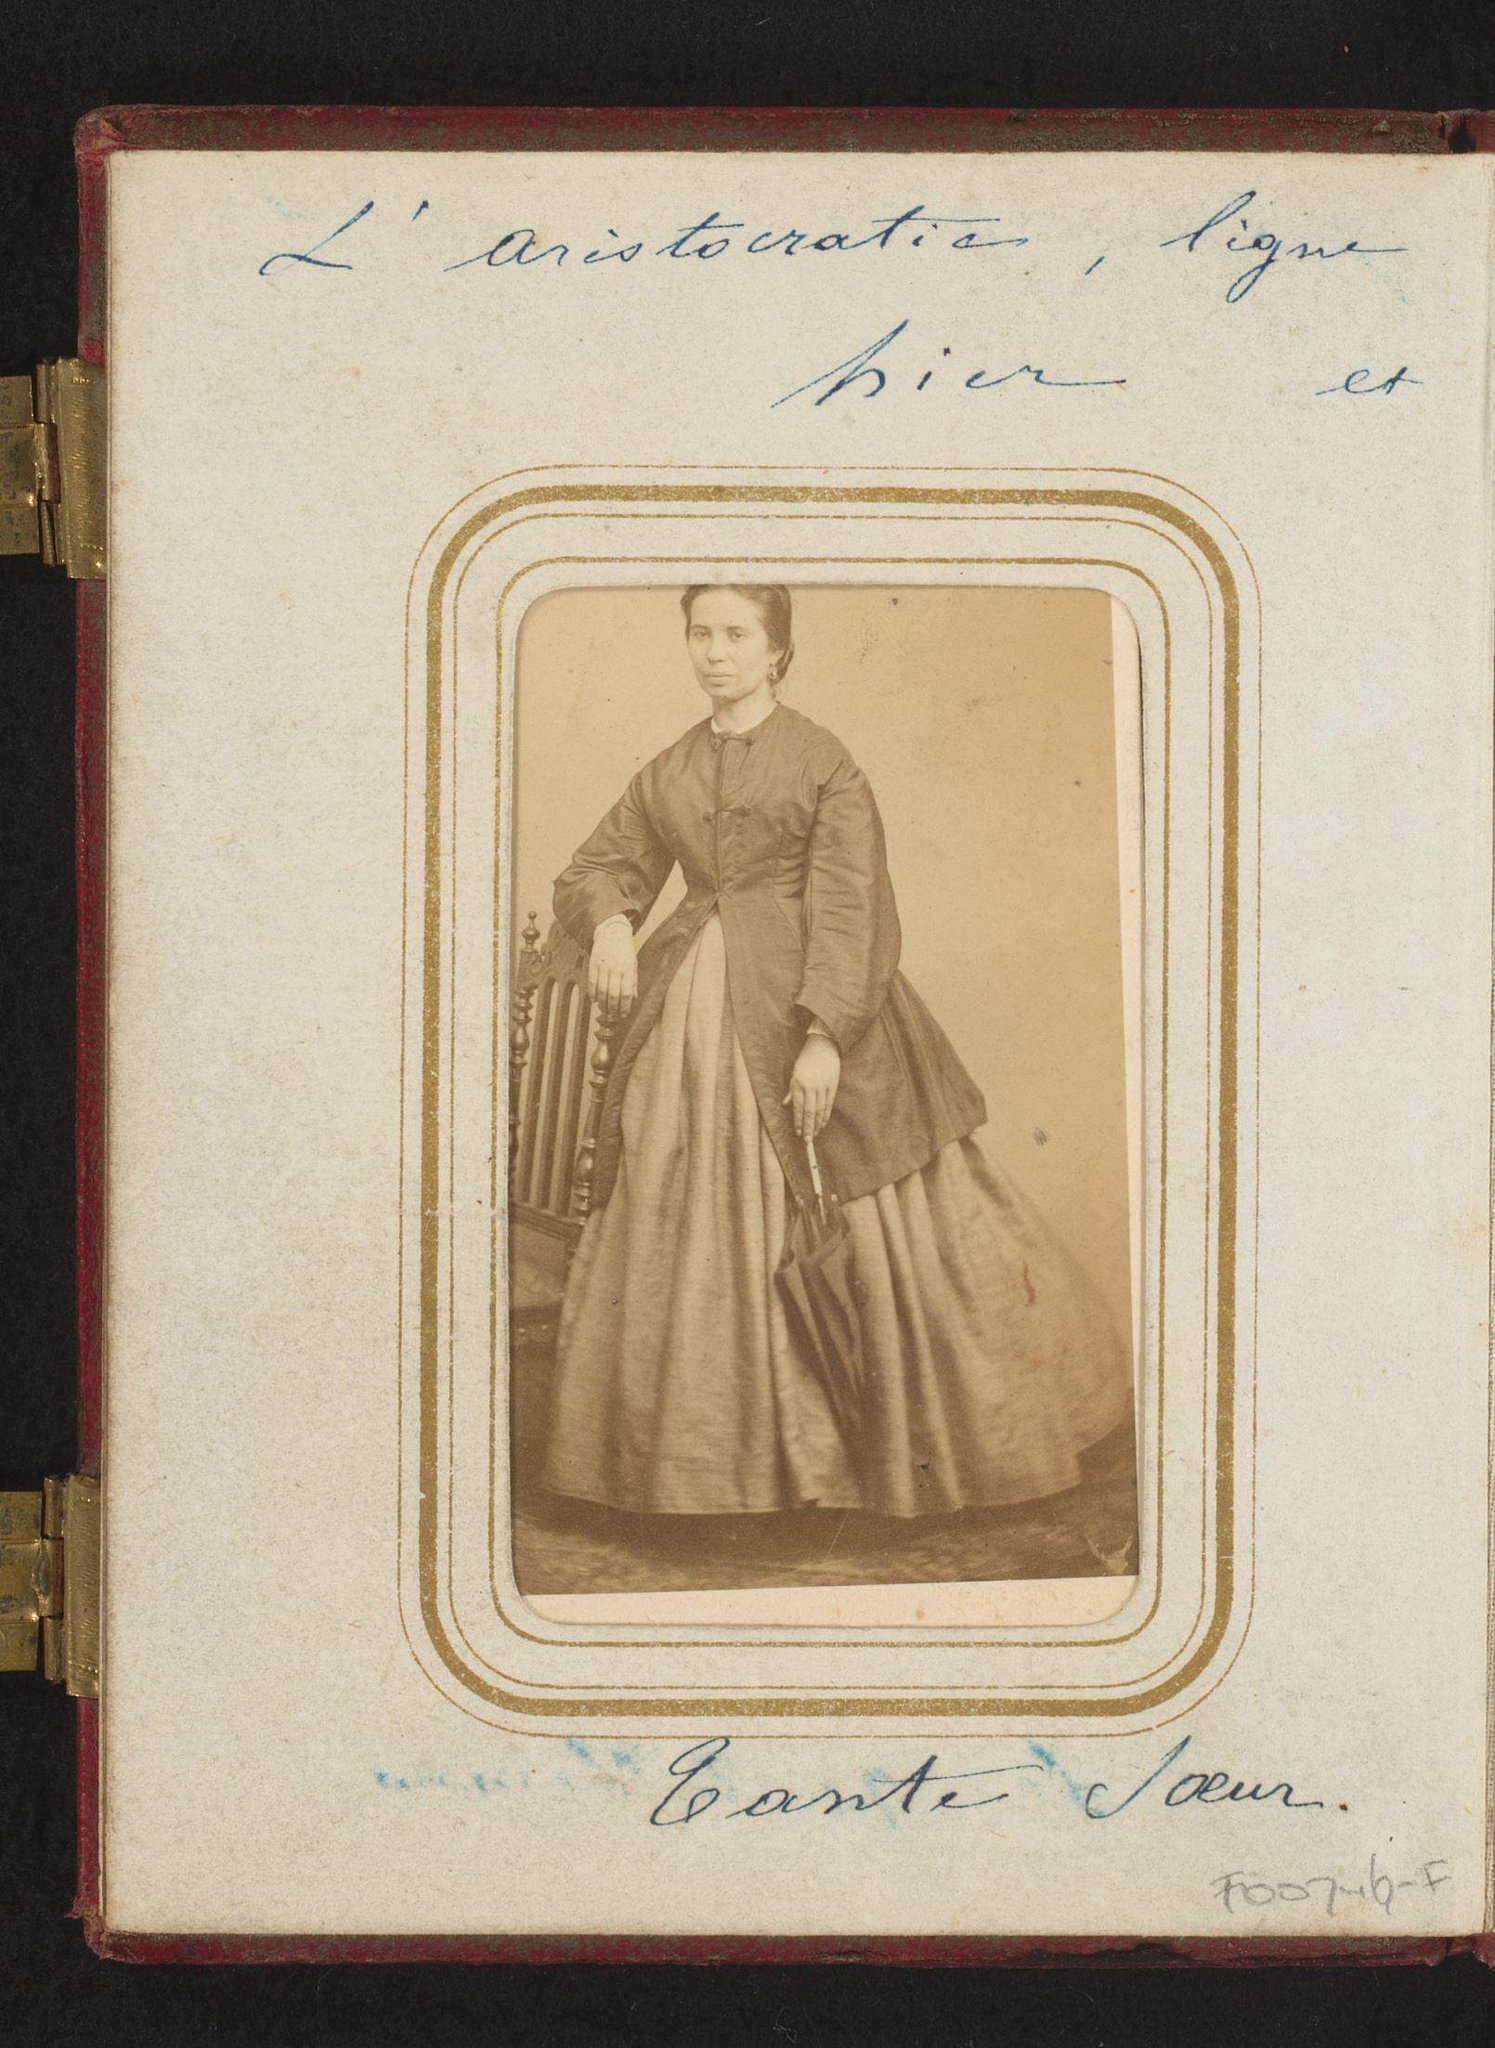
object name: photograph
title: Portret van een staande vrouw met parasol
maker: sabatier (fotograaf)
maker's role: fotograaf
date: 1860-1870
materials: cardboard, photographic support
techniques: albumen print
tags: adult woman, historical persons, umbrella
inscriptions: annotation: ‘L'Aristocratie ligne progressive ascendante/ hier et demain.’, annotation: ‘L ante Joeur’, inscription: ‘Sabatier/ Photographe/ Au Puy’